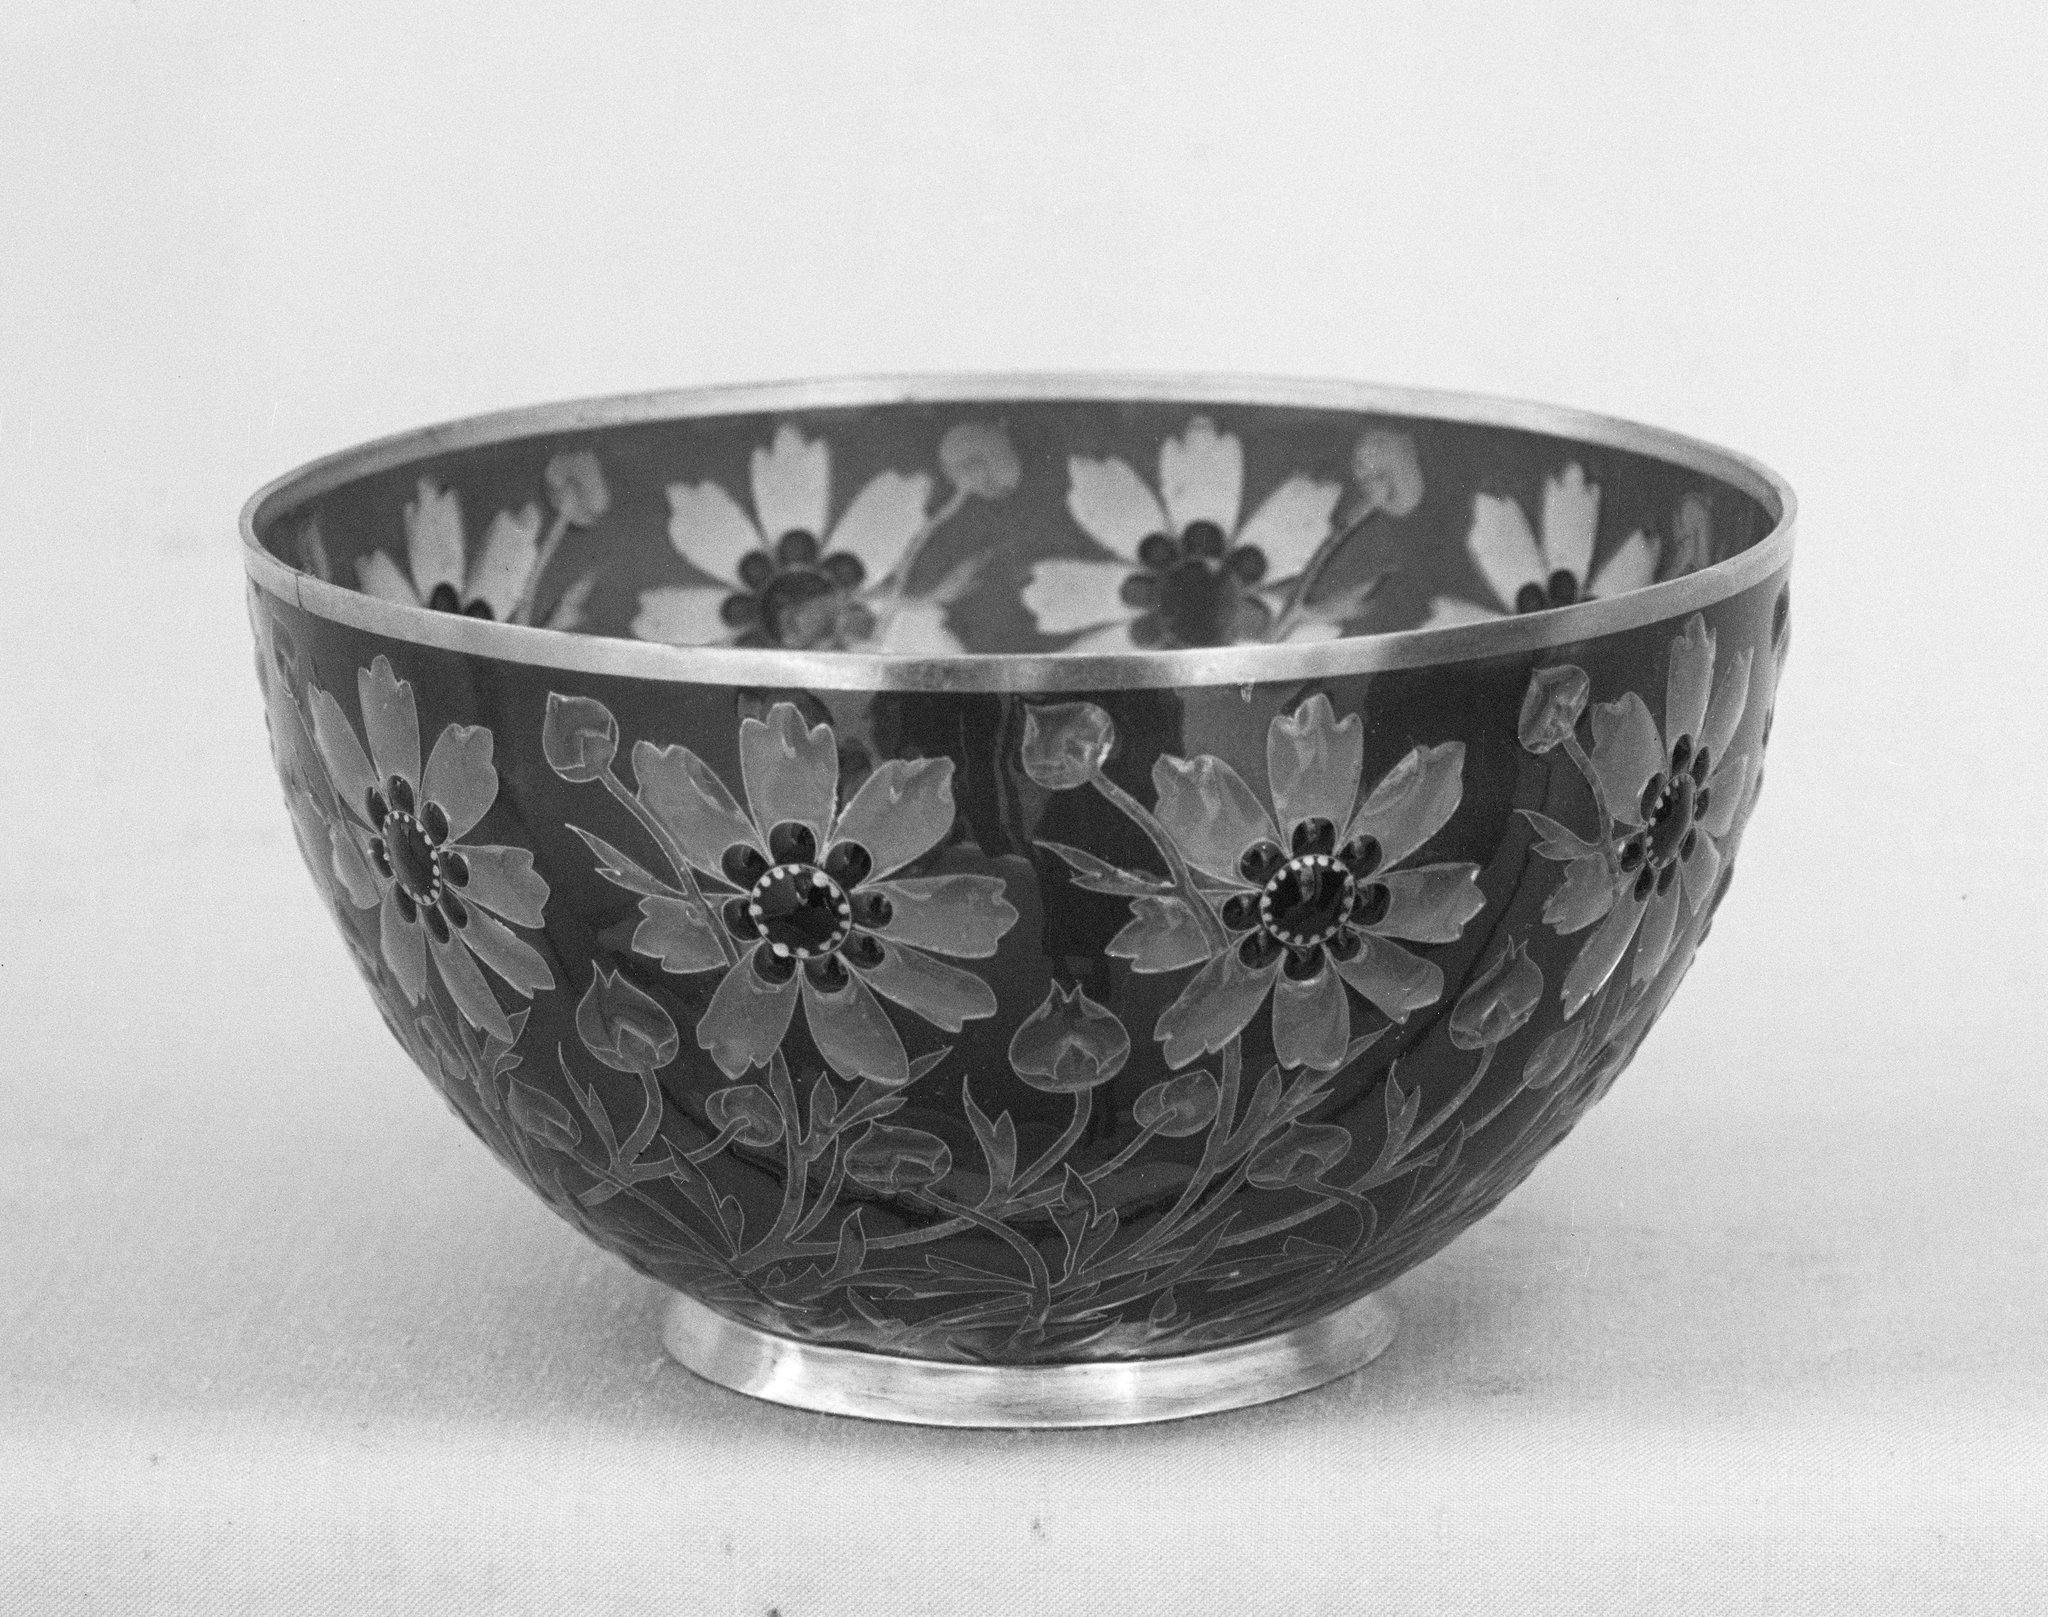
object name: bowl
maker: fernand thesmar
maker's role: maker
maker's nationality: french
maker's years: 1843-1912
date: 1903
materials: enamel, gold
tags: flowers